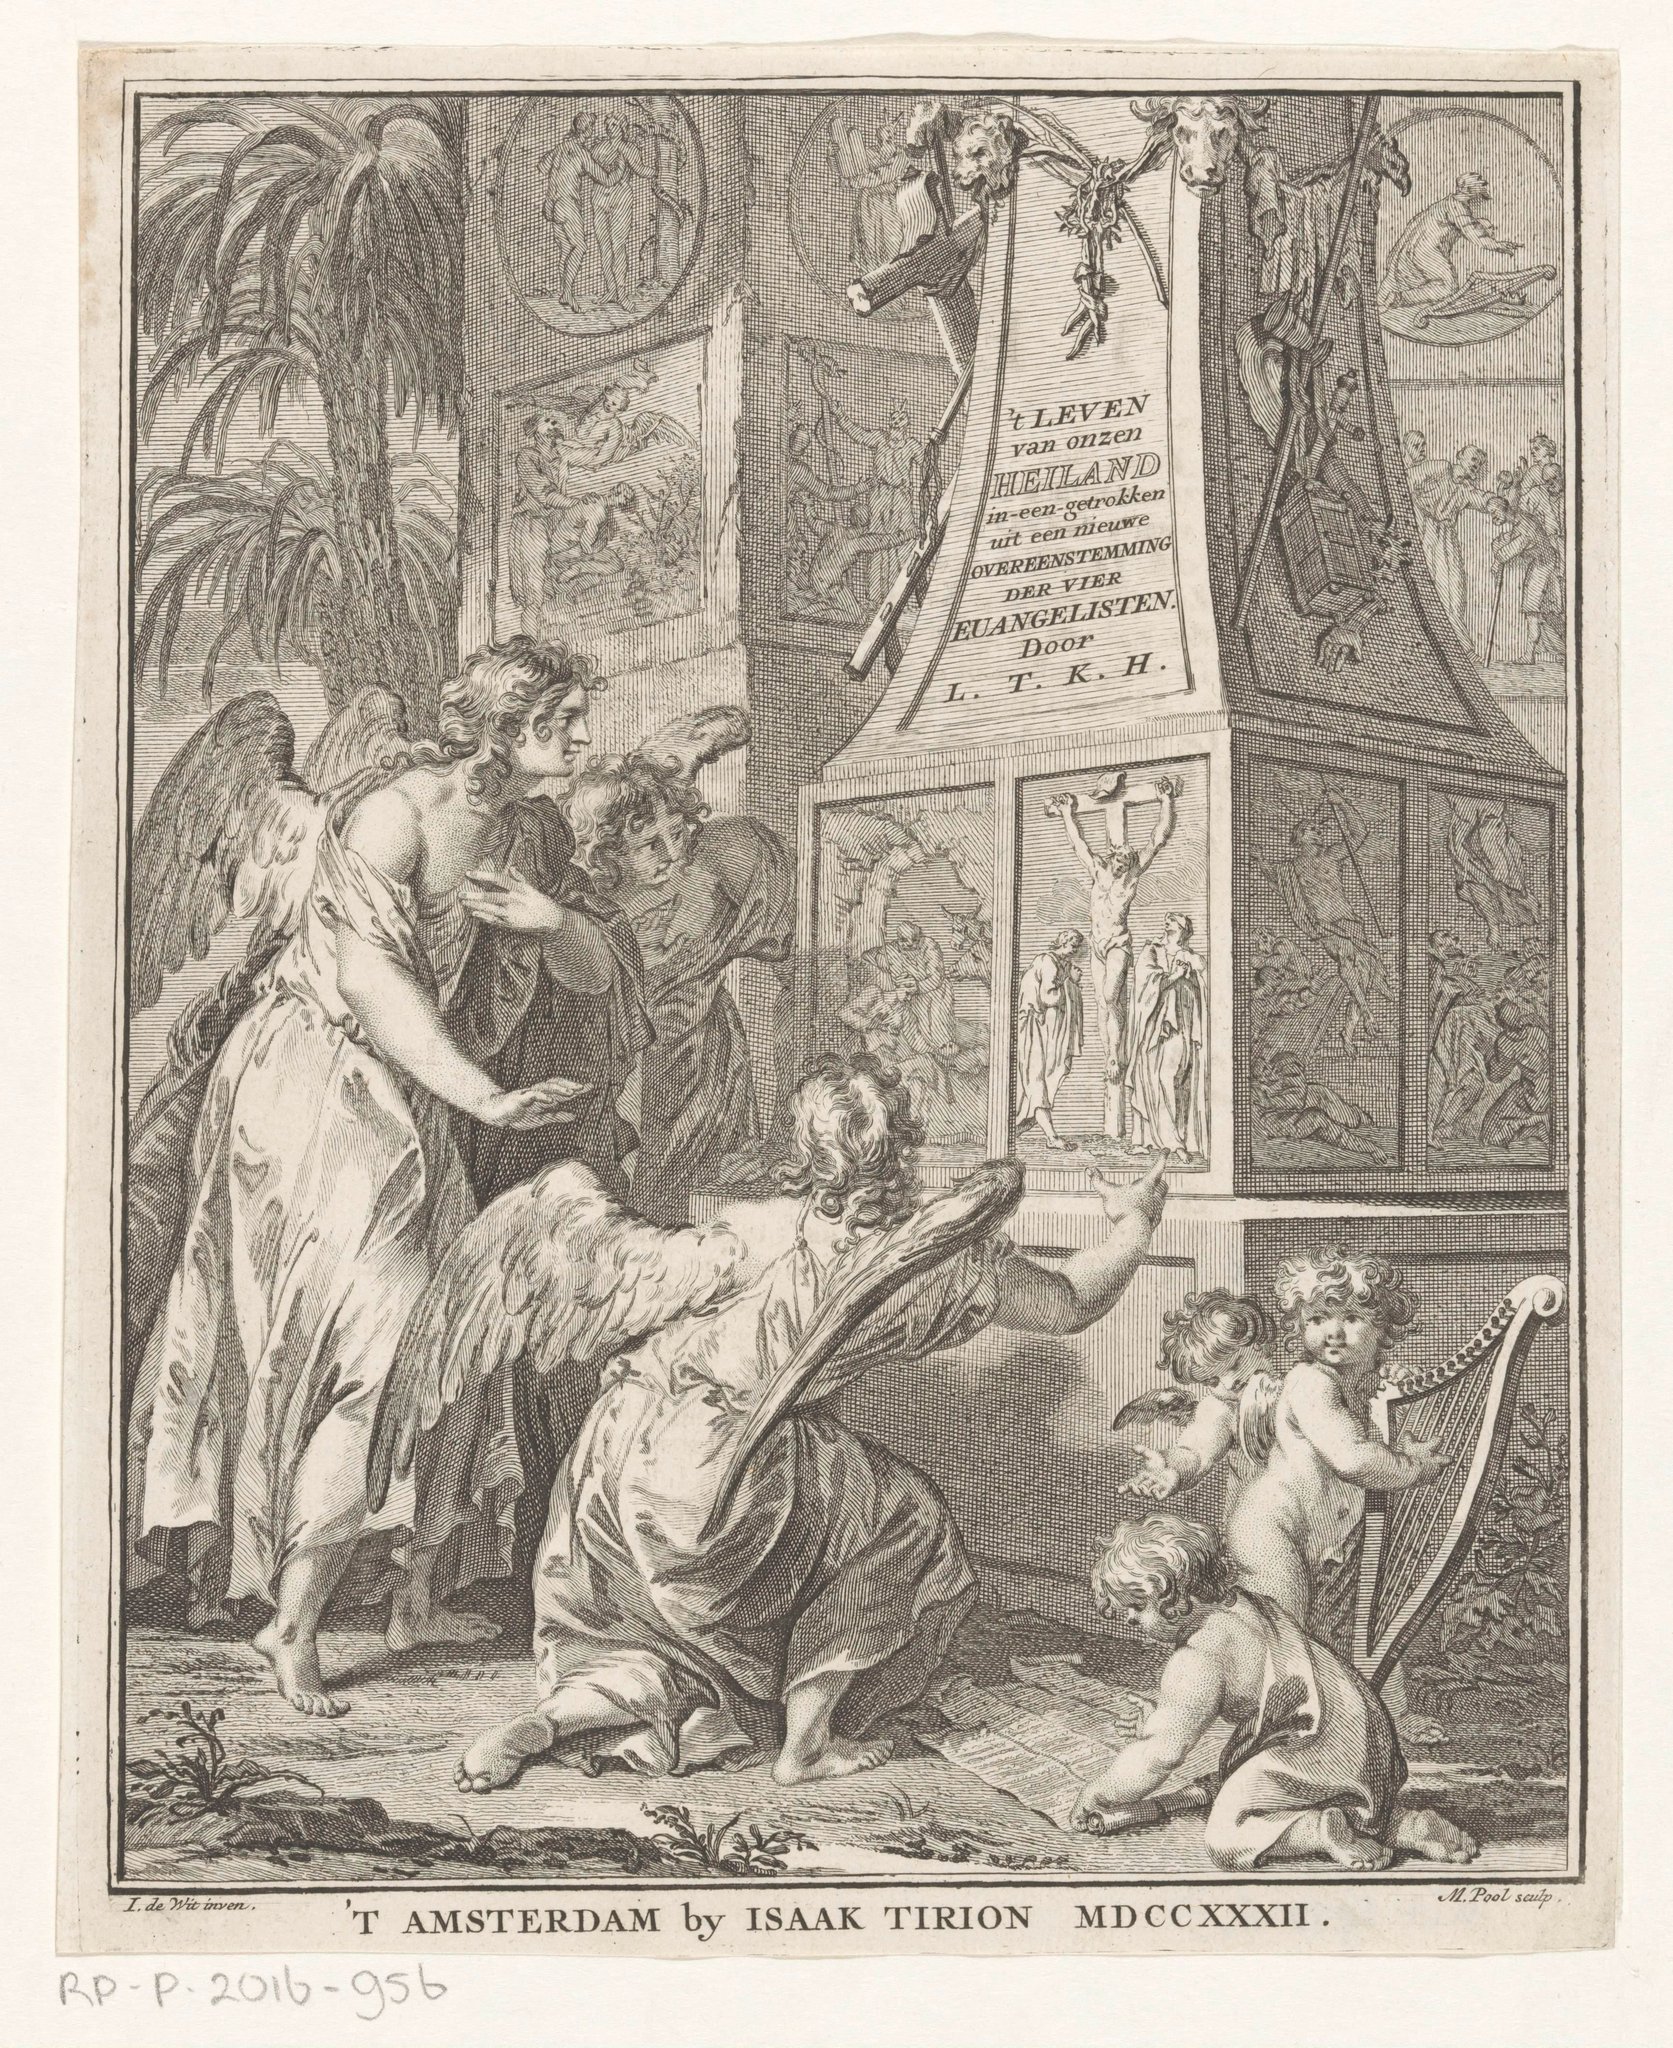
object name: print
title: Drie engelen bewonderen een obelisk met scènes uit het Nieuwe Testament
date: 1732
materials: paper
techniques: engraving, etching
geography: amsterdam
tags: obelisks (garden ornaments), single instruments of the passion, angels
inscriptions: collector's mark: Lugt 2228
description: Landschap met drie engelen bij een obelisk. Op het monument de titel in het Nederlands, te midden van passiewerktuigen en andere attributen die verwijzen naar het leven van Christus. Op het basement scènes uit het Nieuwe Testament, respectievelijk de geboorte van Christus, de kruisiging, de opstanding en de hemelvaart. Op de achtergrond een zuil met scènes uit het Oude Testament. Op de voorgrond drie putti. Eén van hen bespeelt een harp, een ander rolt papier uit op de grond.